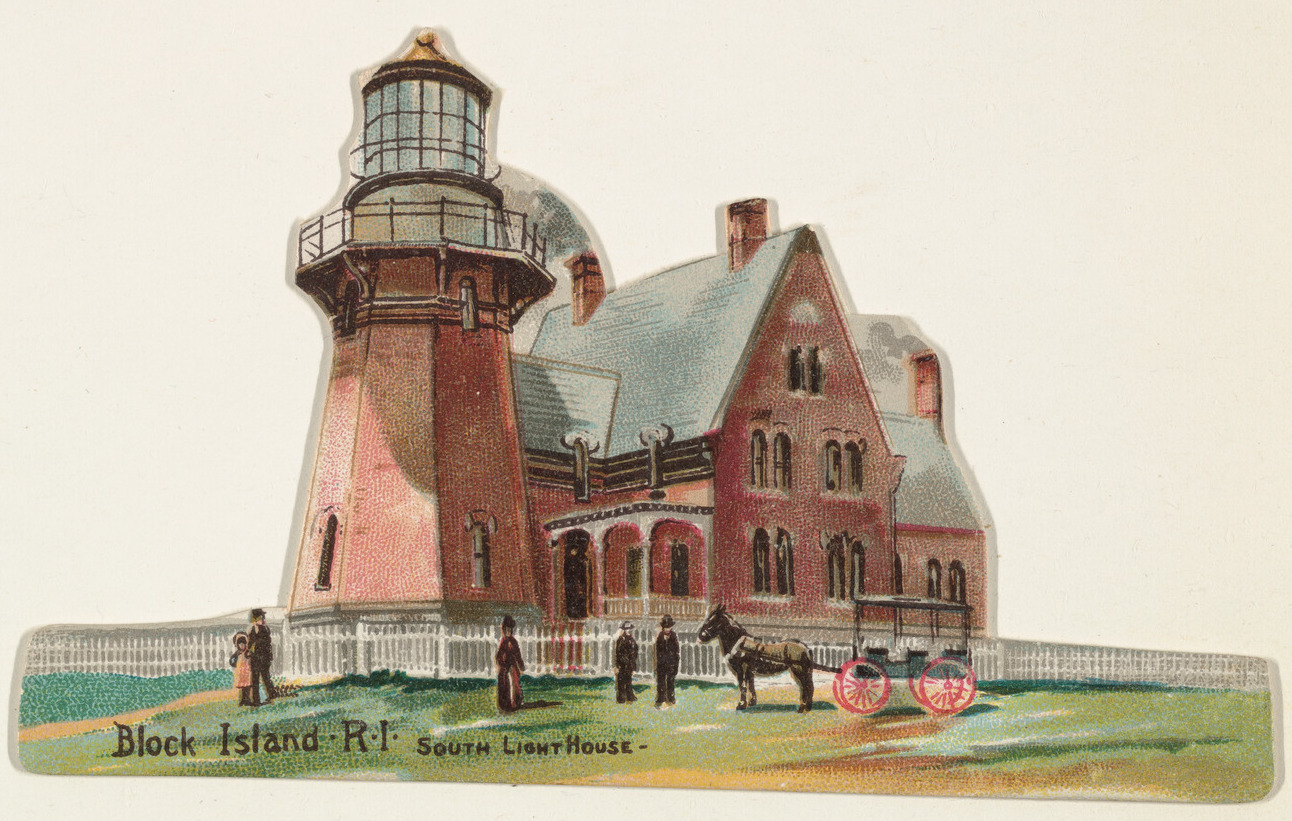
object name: print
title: Block Island, Rhode Island, from the Lighthouses series (N119) issued by Duke Sons & Co. to promote Honest Long Cut Tobacco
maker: w. duke, sons & co.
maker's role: publisher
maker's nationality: american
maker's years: 1870-1920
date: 1889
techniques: color lithograph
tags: lighthouses